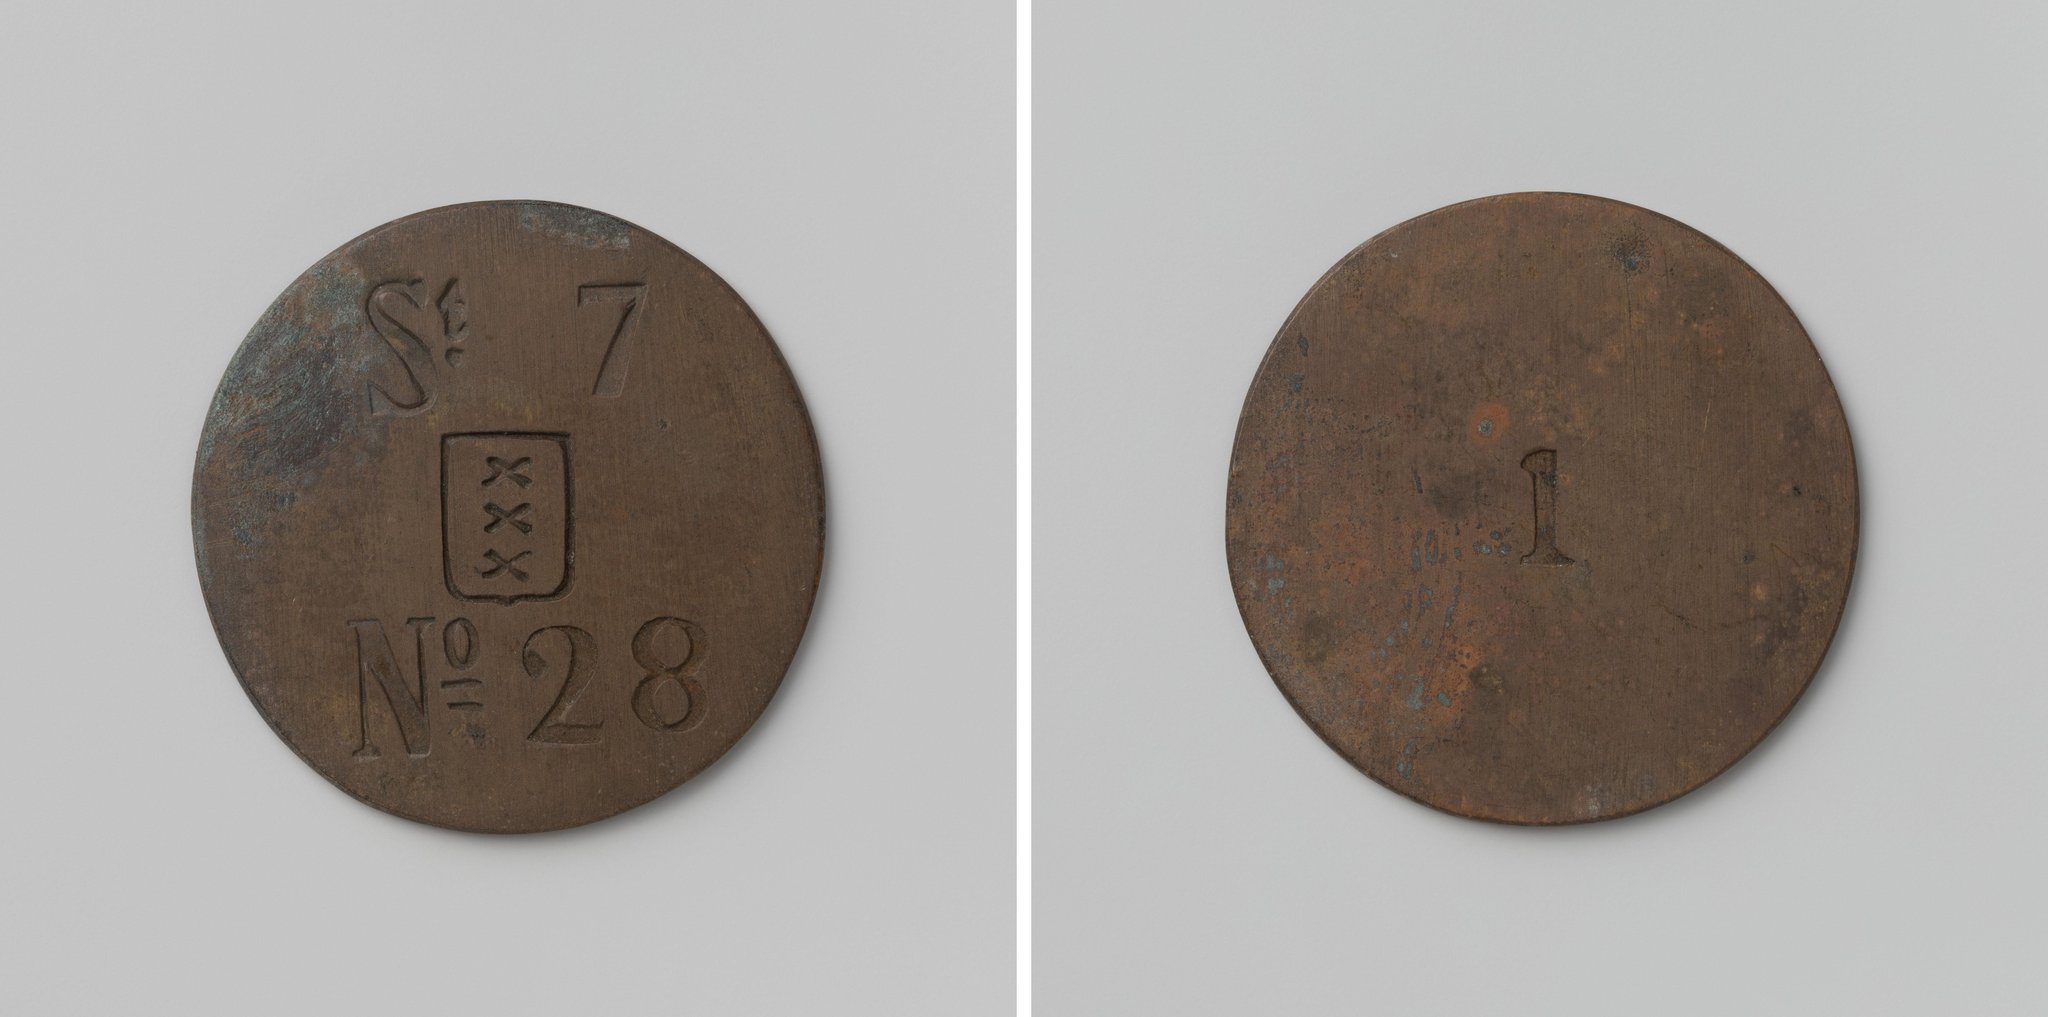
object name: medal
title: Amsterdam, brandspuitpenning van spuit 7 met no. 28 en no. 1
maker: Anonymous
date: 1680-1800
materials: copper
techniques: engraving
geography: amsterdam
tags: amsterdam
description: Koperen penning. Voorzijde: opschrift St. 7 boven wapenschild en opschrift No. 28. Keerzijde: cijfer 1